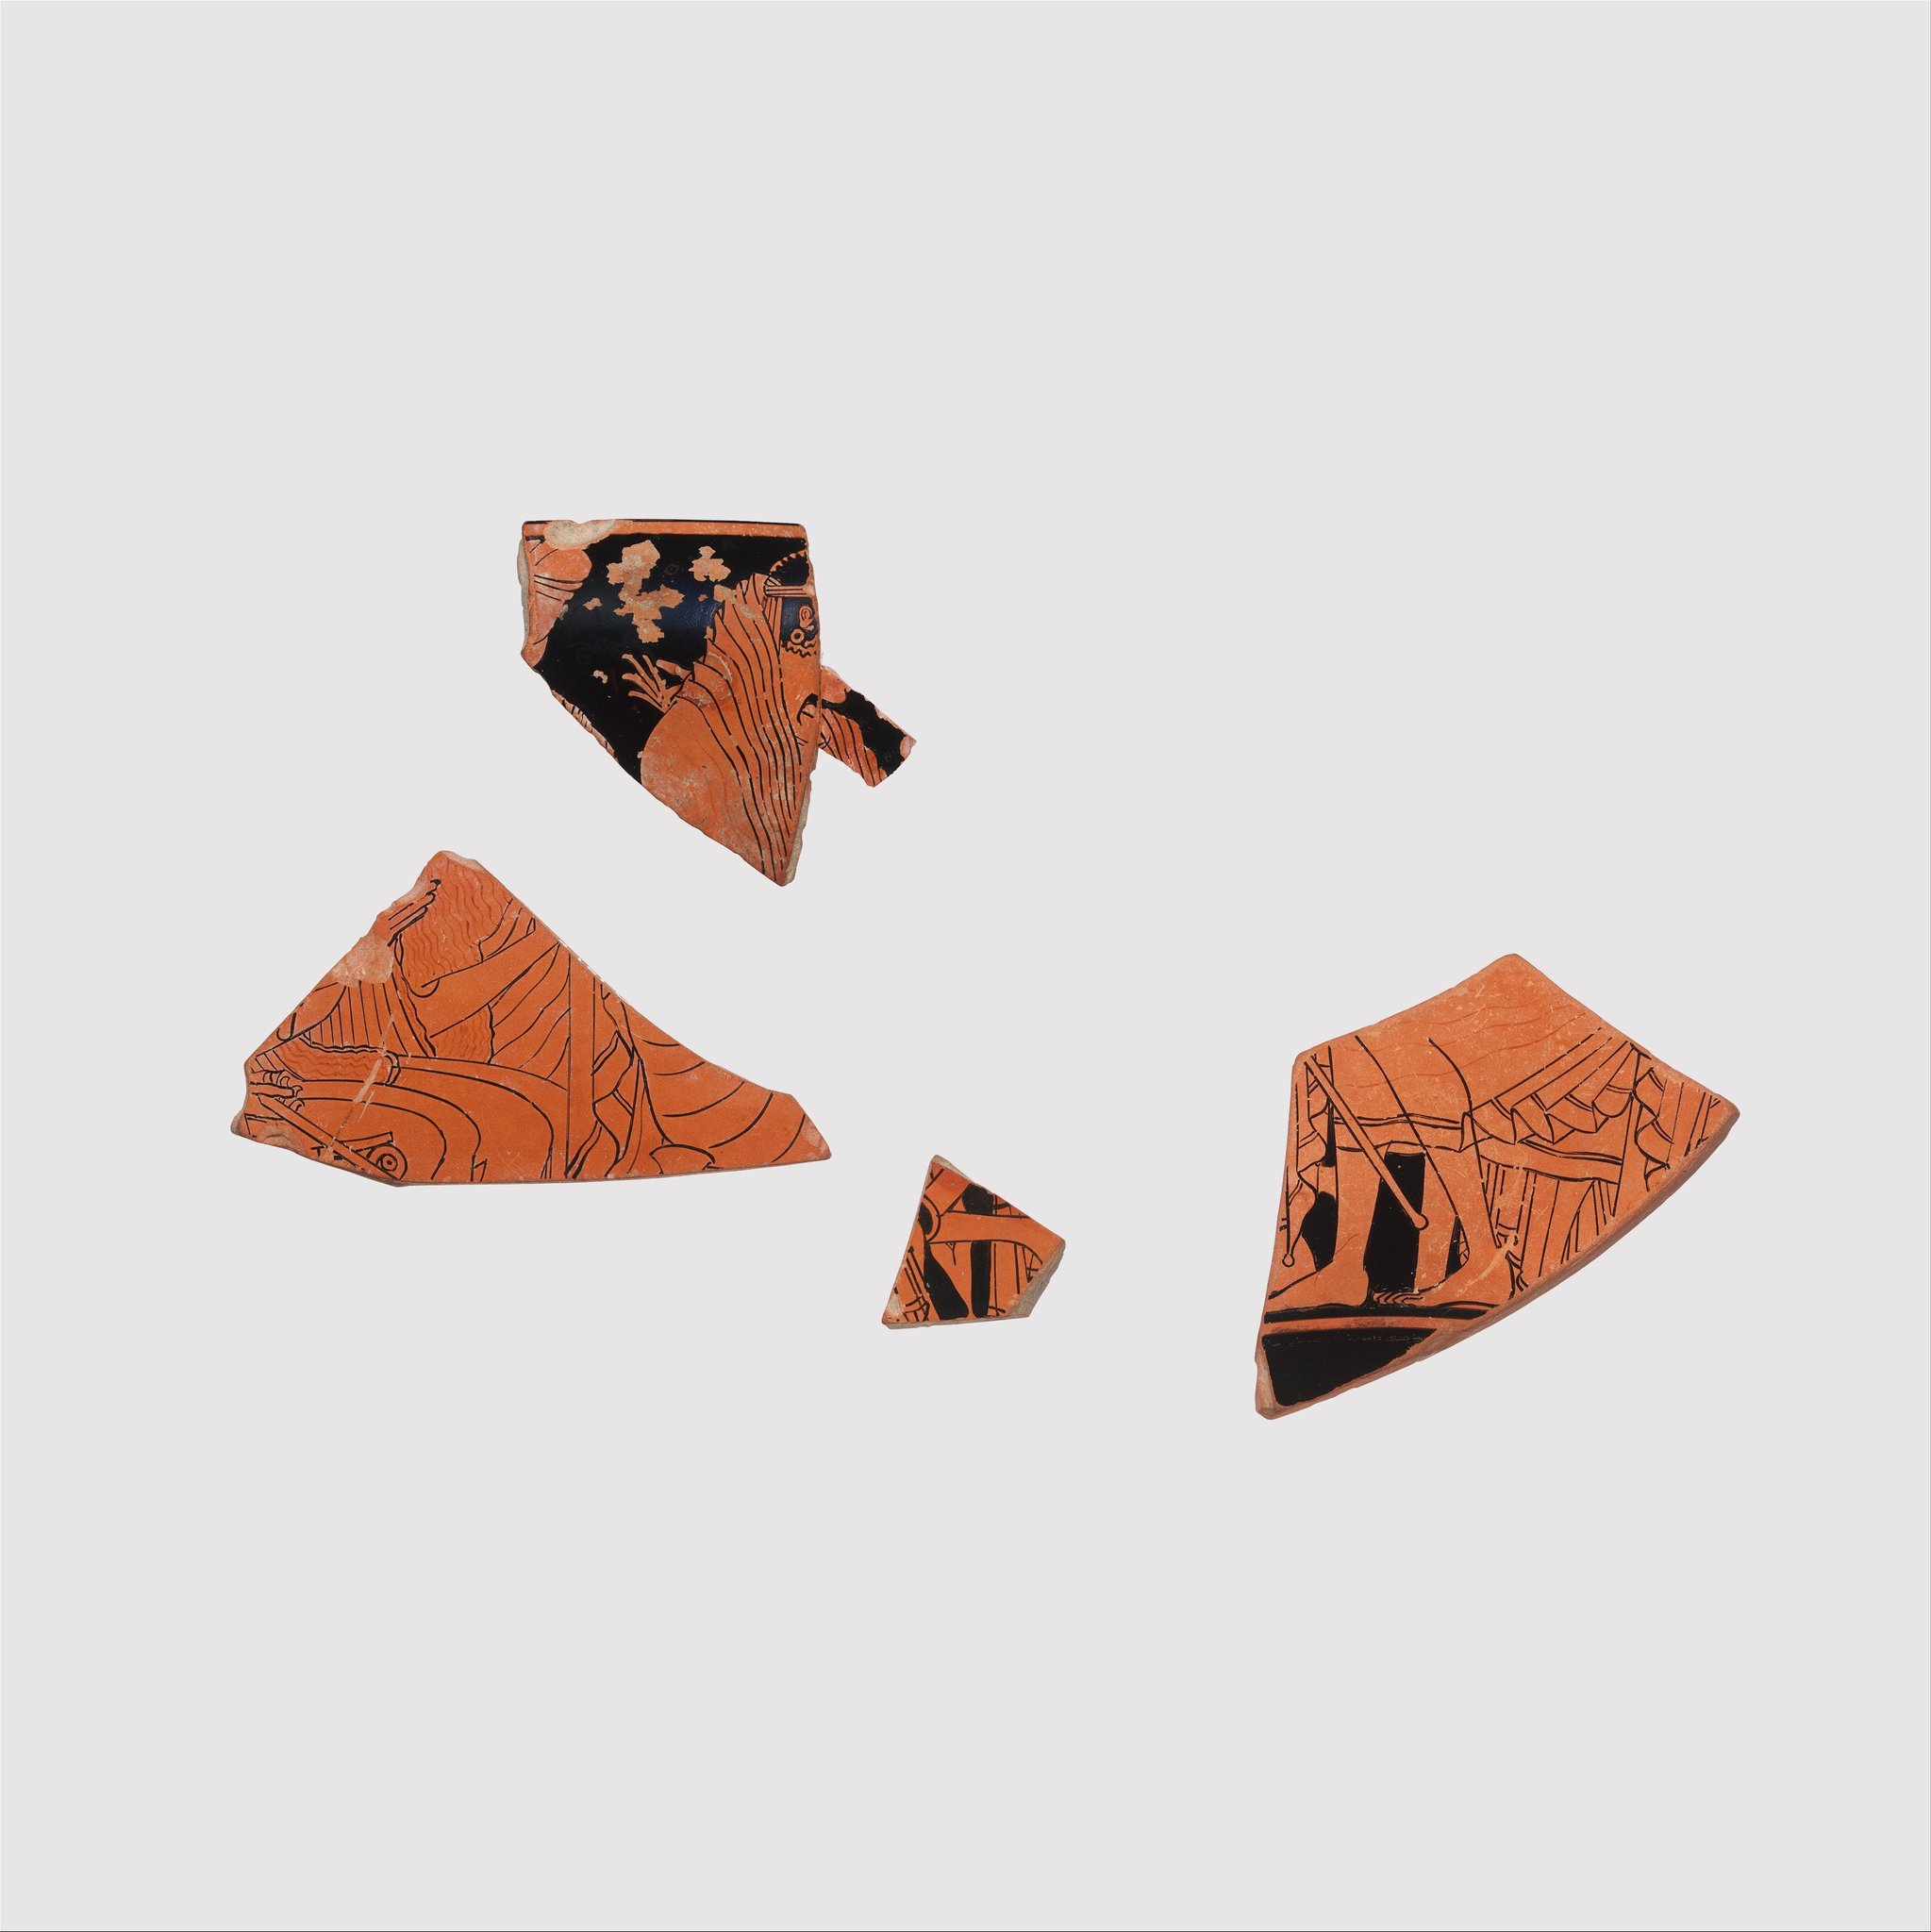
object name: kylix fragment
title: Fragments of a terracotta kylix (drinking cup)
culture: greek, attic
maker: euthymides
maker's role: artist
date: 515 BCE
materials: terracotta